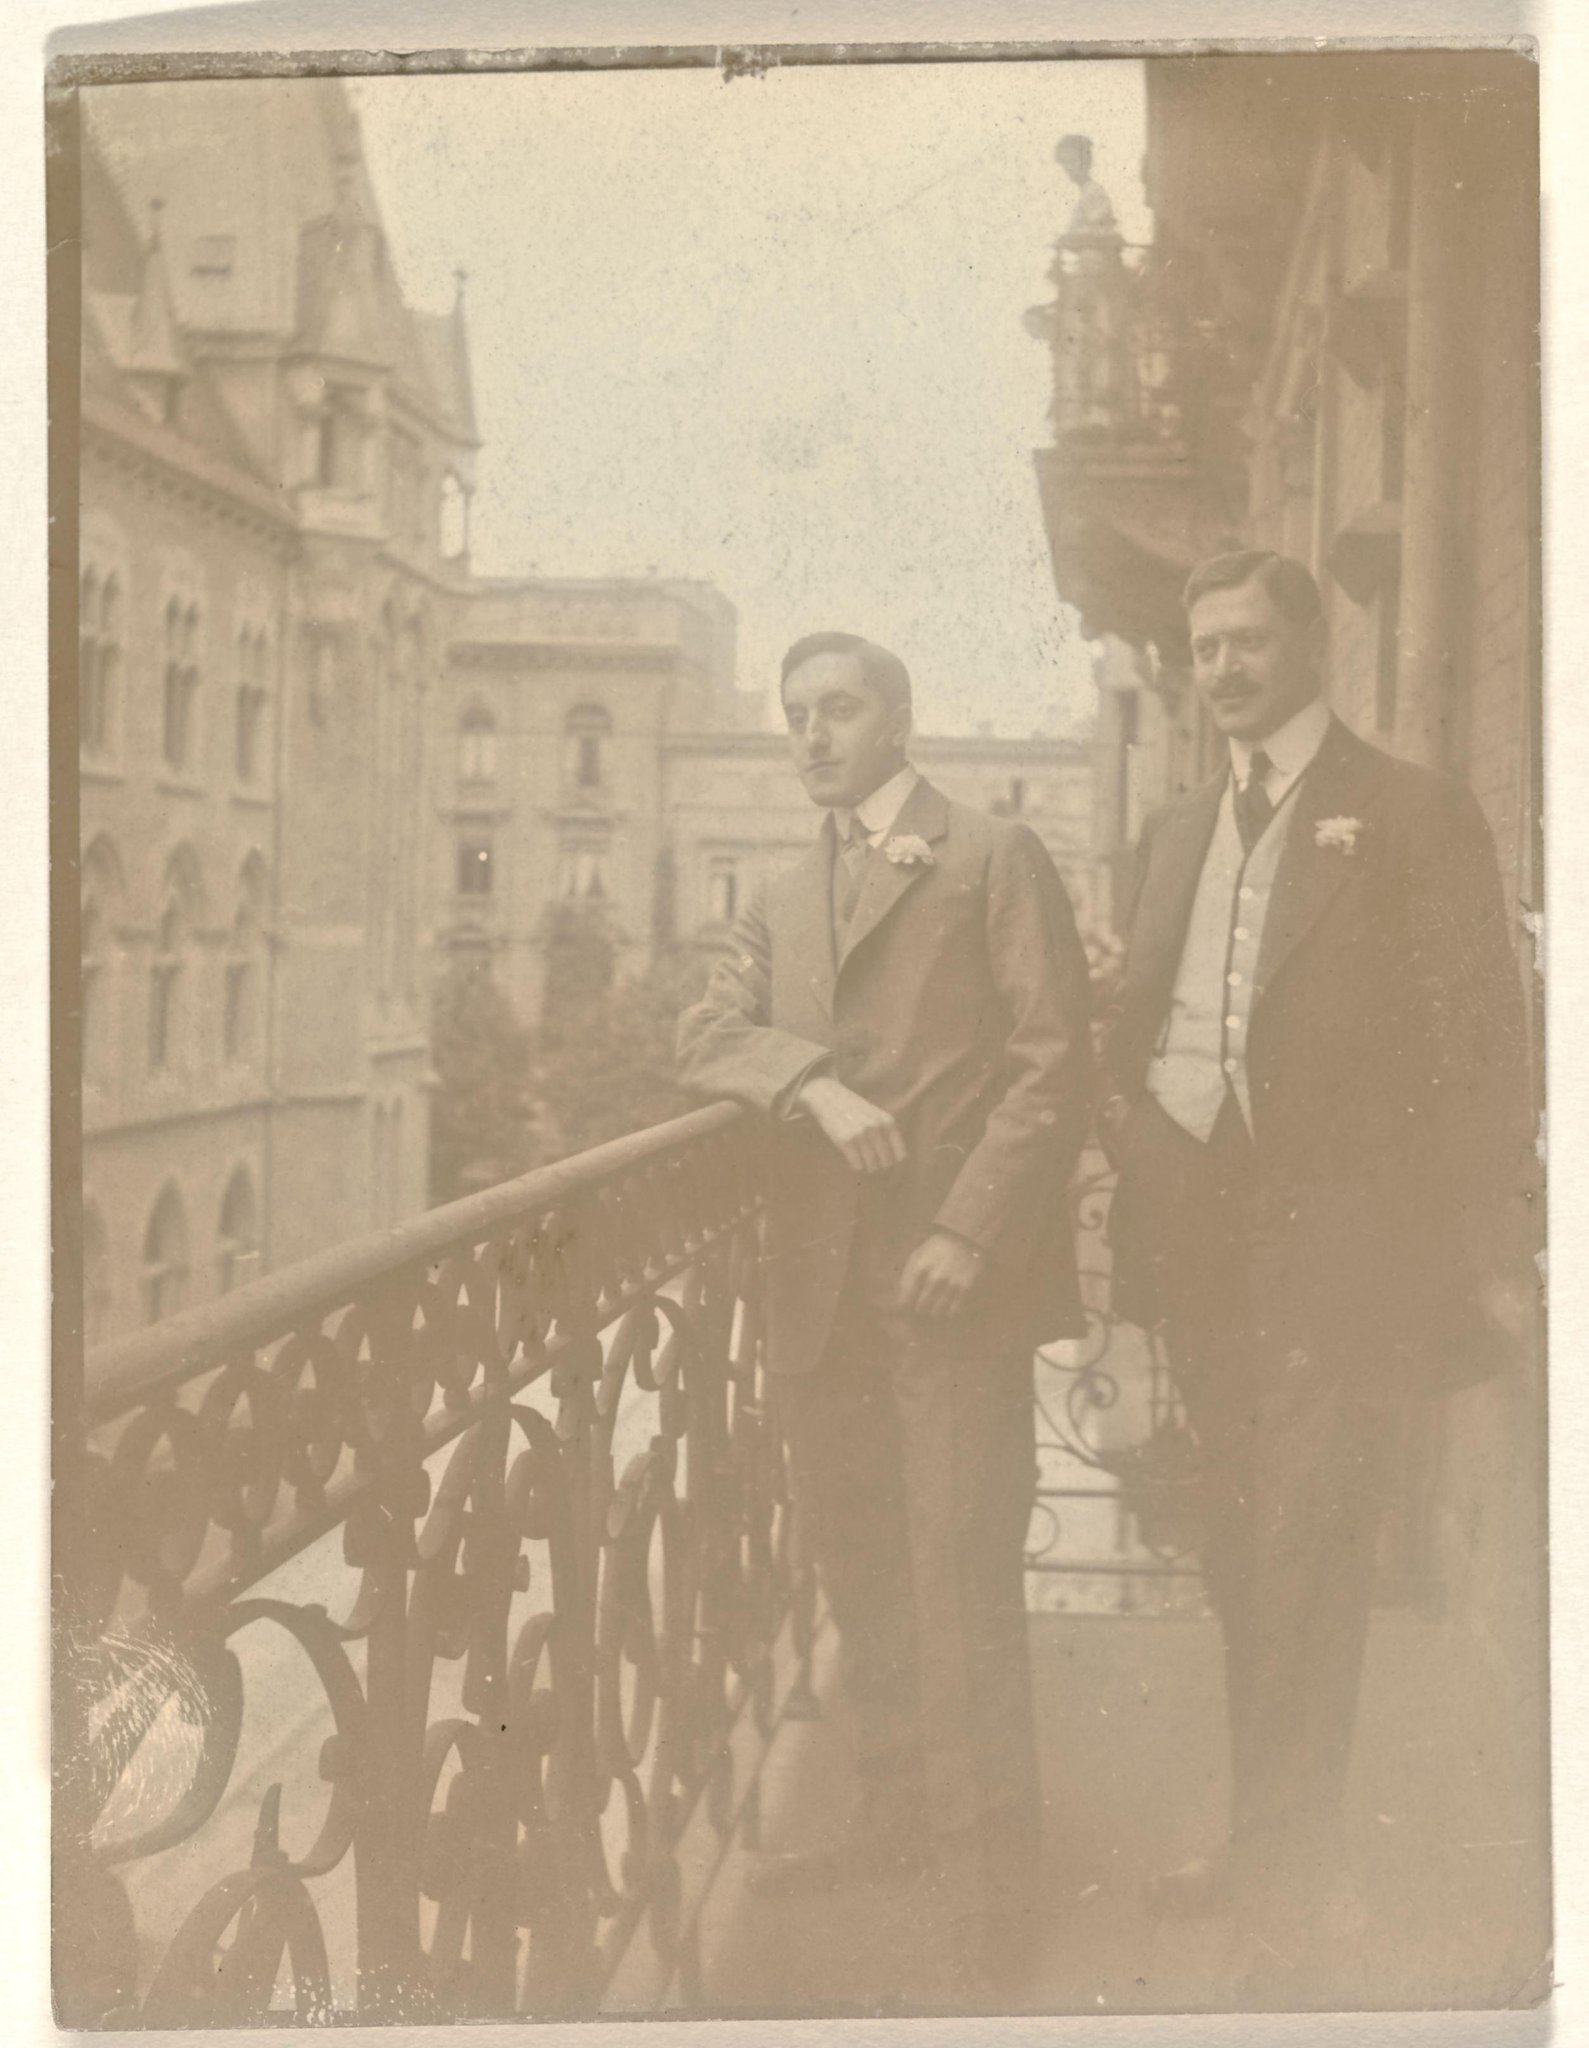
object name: photograph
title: Eugen Wachenheimer als jongeman met een onbekende man op een balkon, 1906-1926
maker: Anonymous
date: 1906-1926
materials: photographic support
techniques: gelatin silver print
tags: eugen wachenheimer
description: Eugen Wachenheimer als jongeman met een onbekende man op een balkon.